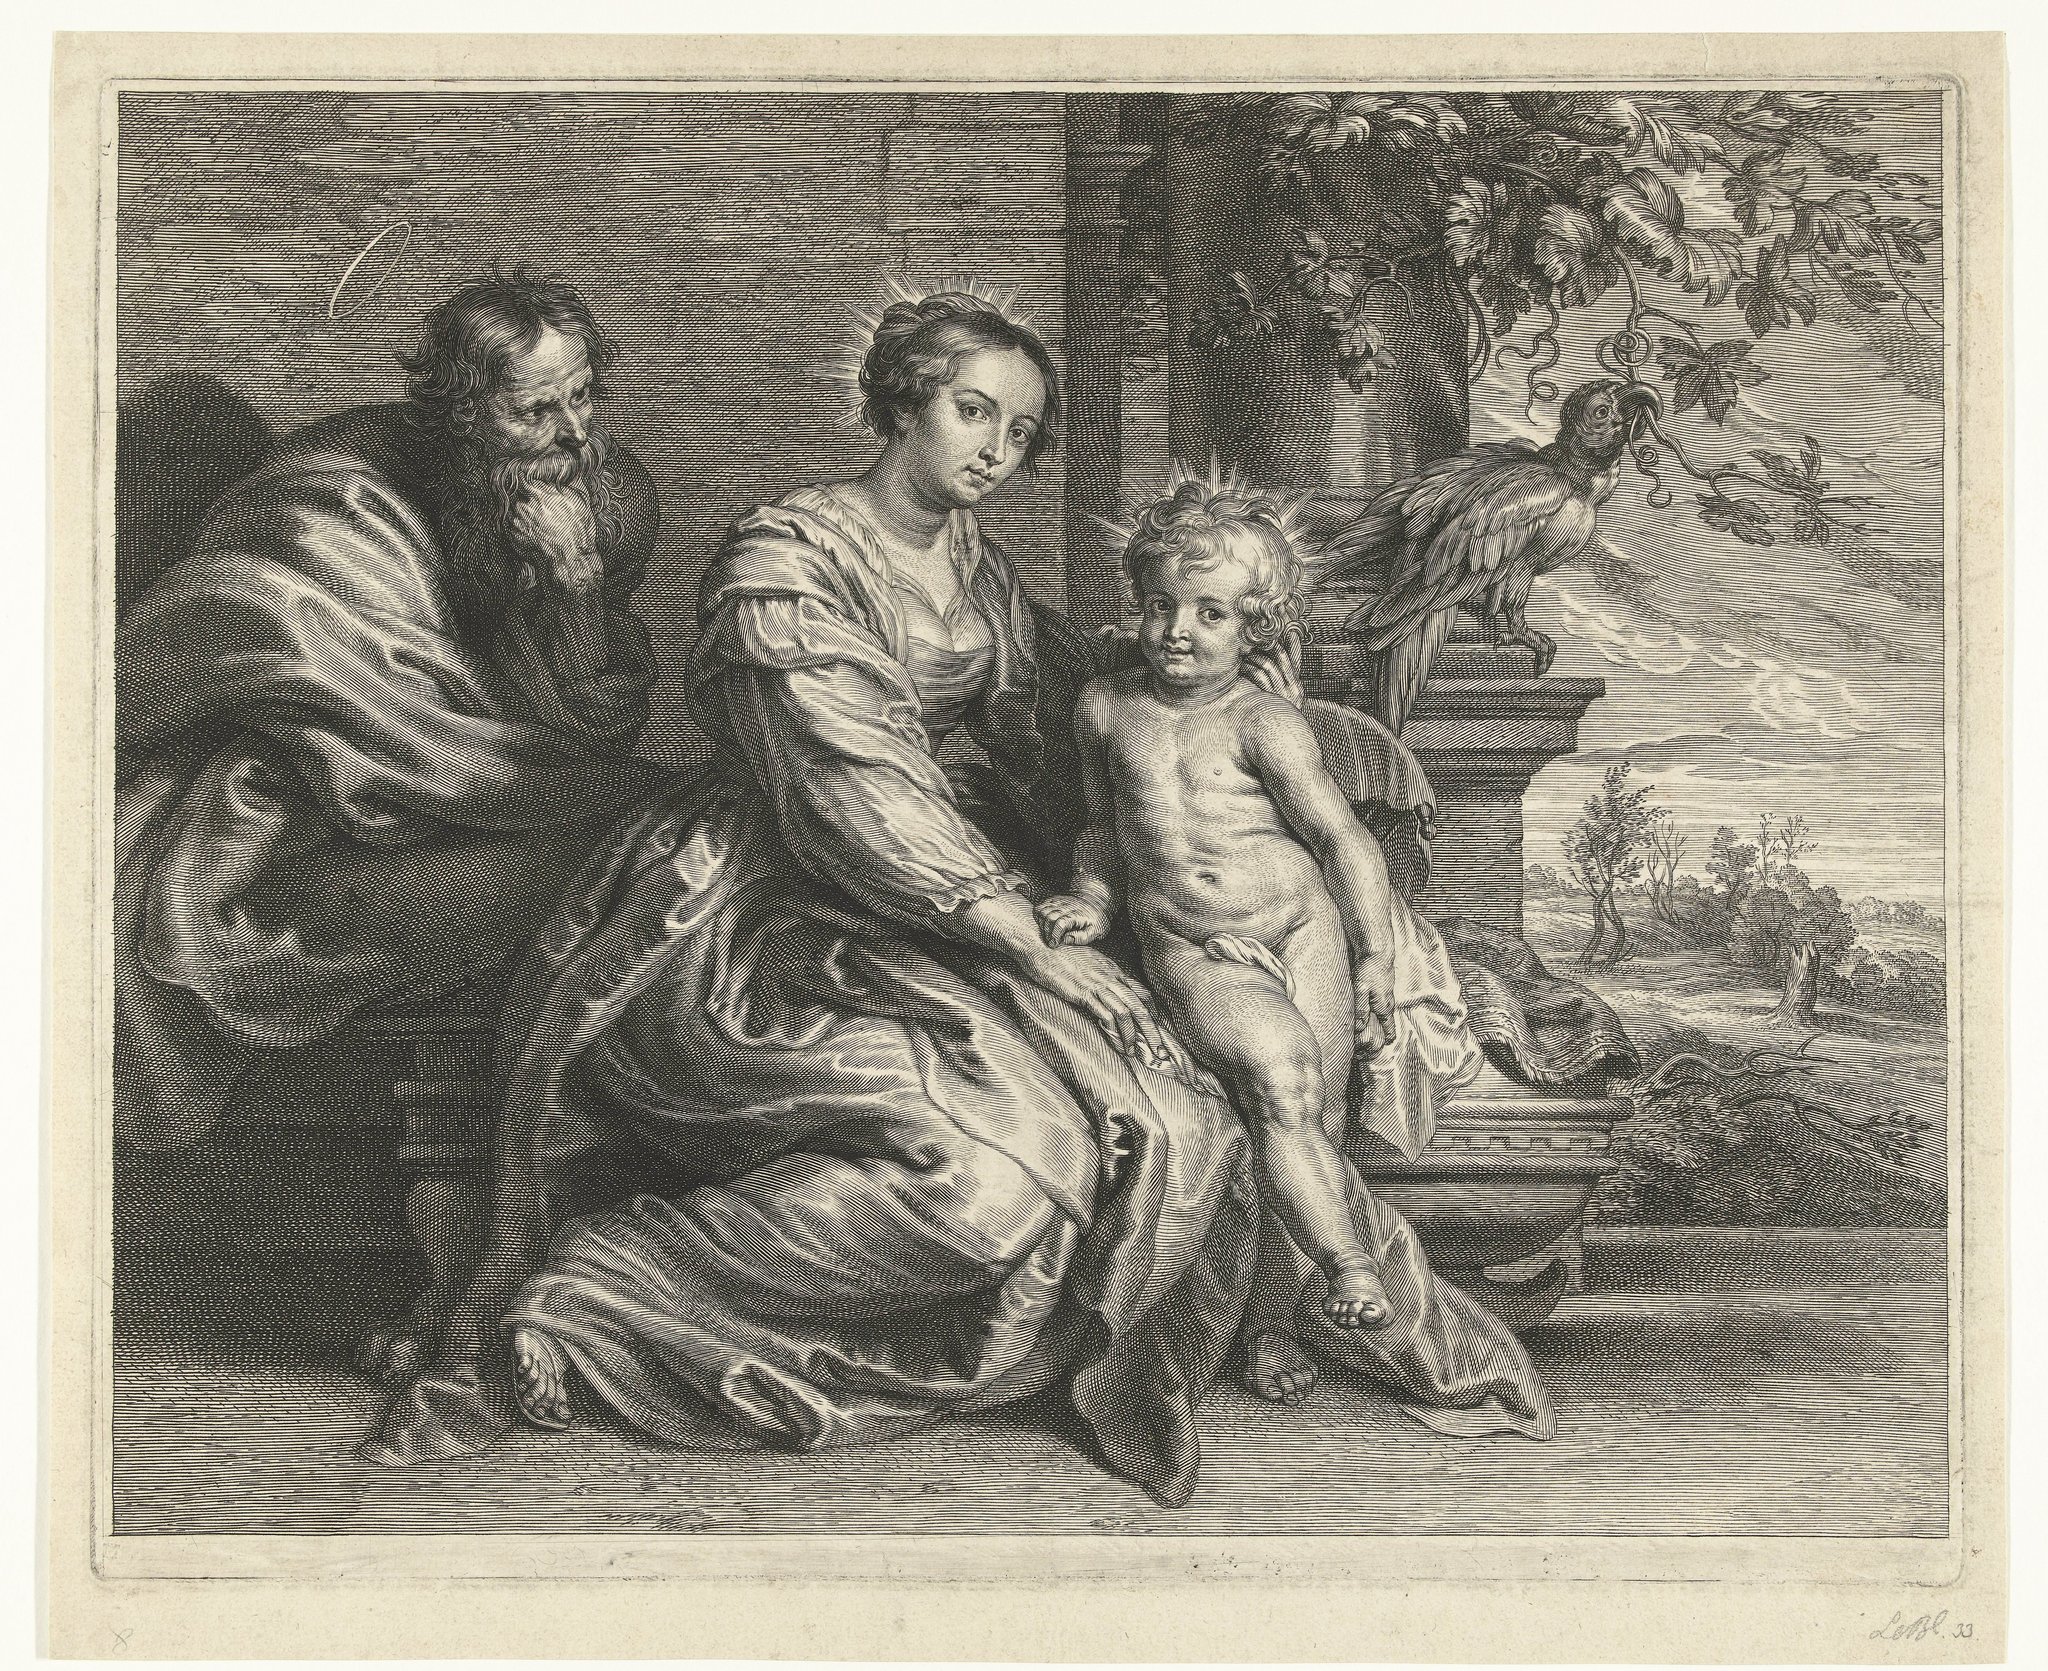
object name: print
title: Heilige familie met papegaai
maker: schelte adamsz. bolswert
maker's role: print maker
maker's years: 1586-1659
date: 1596-1659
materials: paper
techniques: engraving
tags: vine, holy family, and derived representations, ornamental birds: parrot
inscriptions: collector's mark: Lugt 240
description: Prent naar schilderij van Peter Paul Rubens.